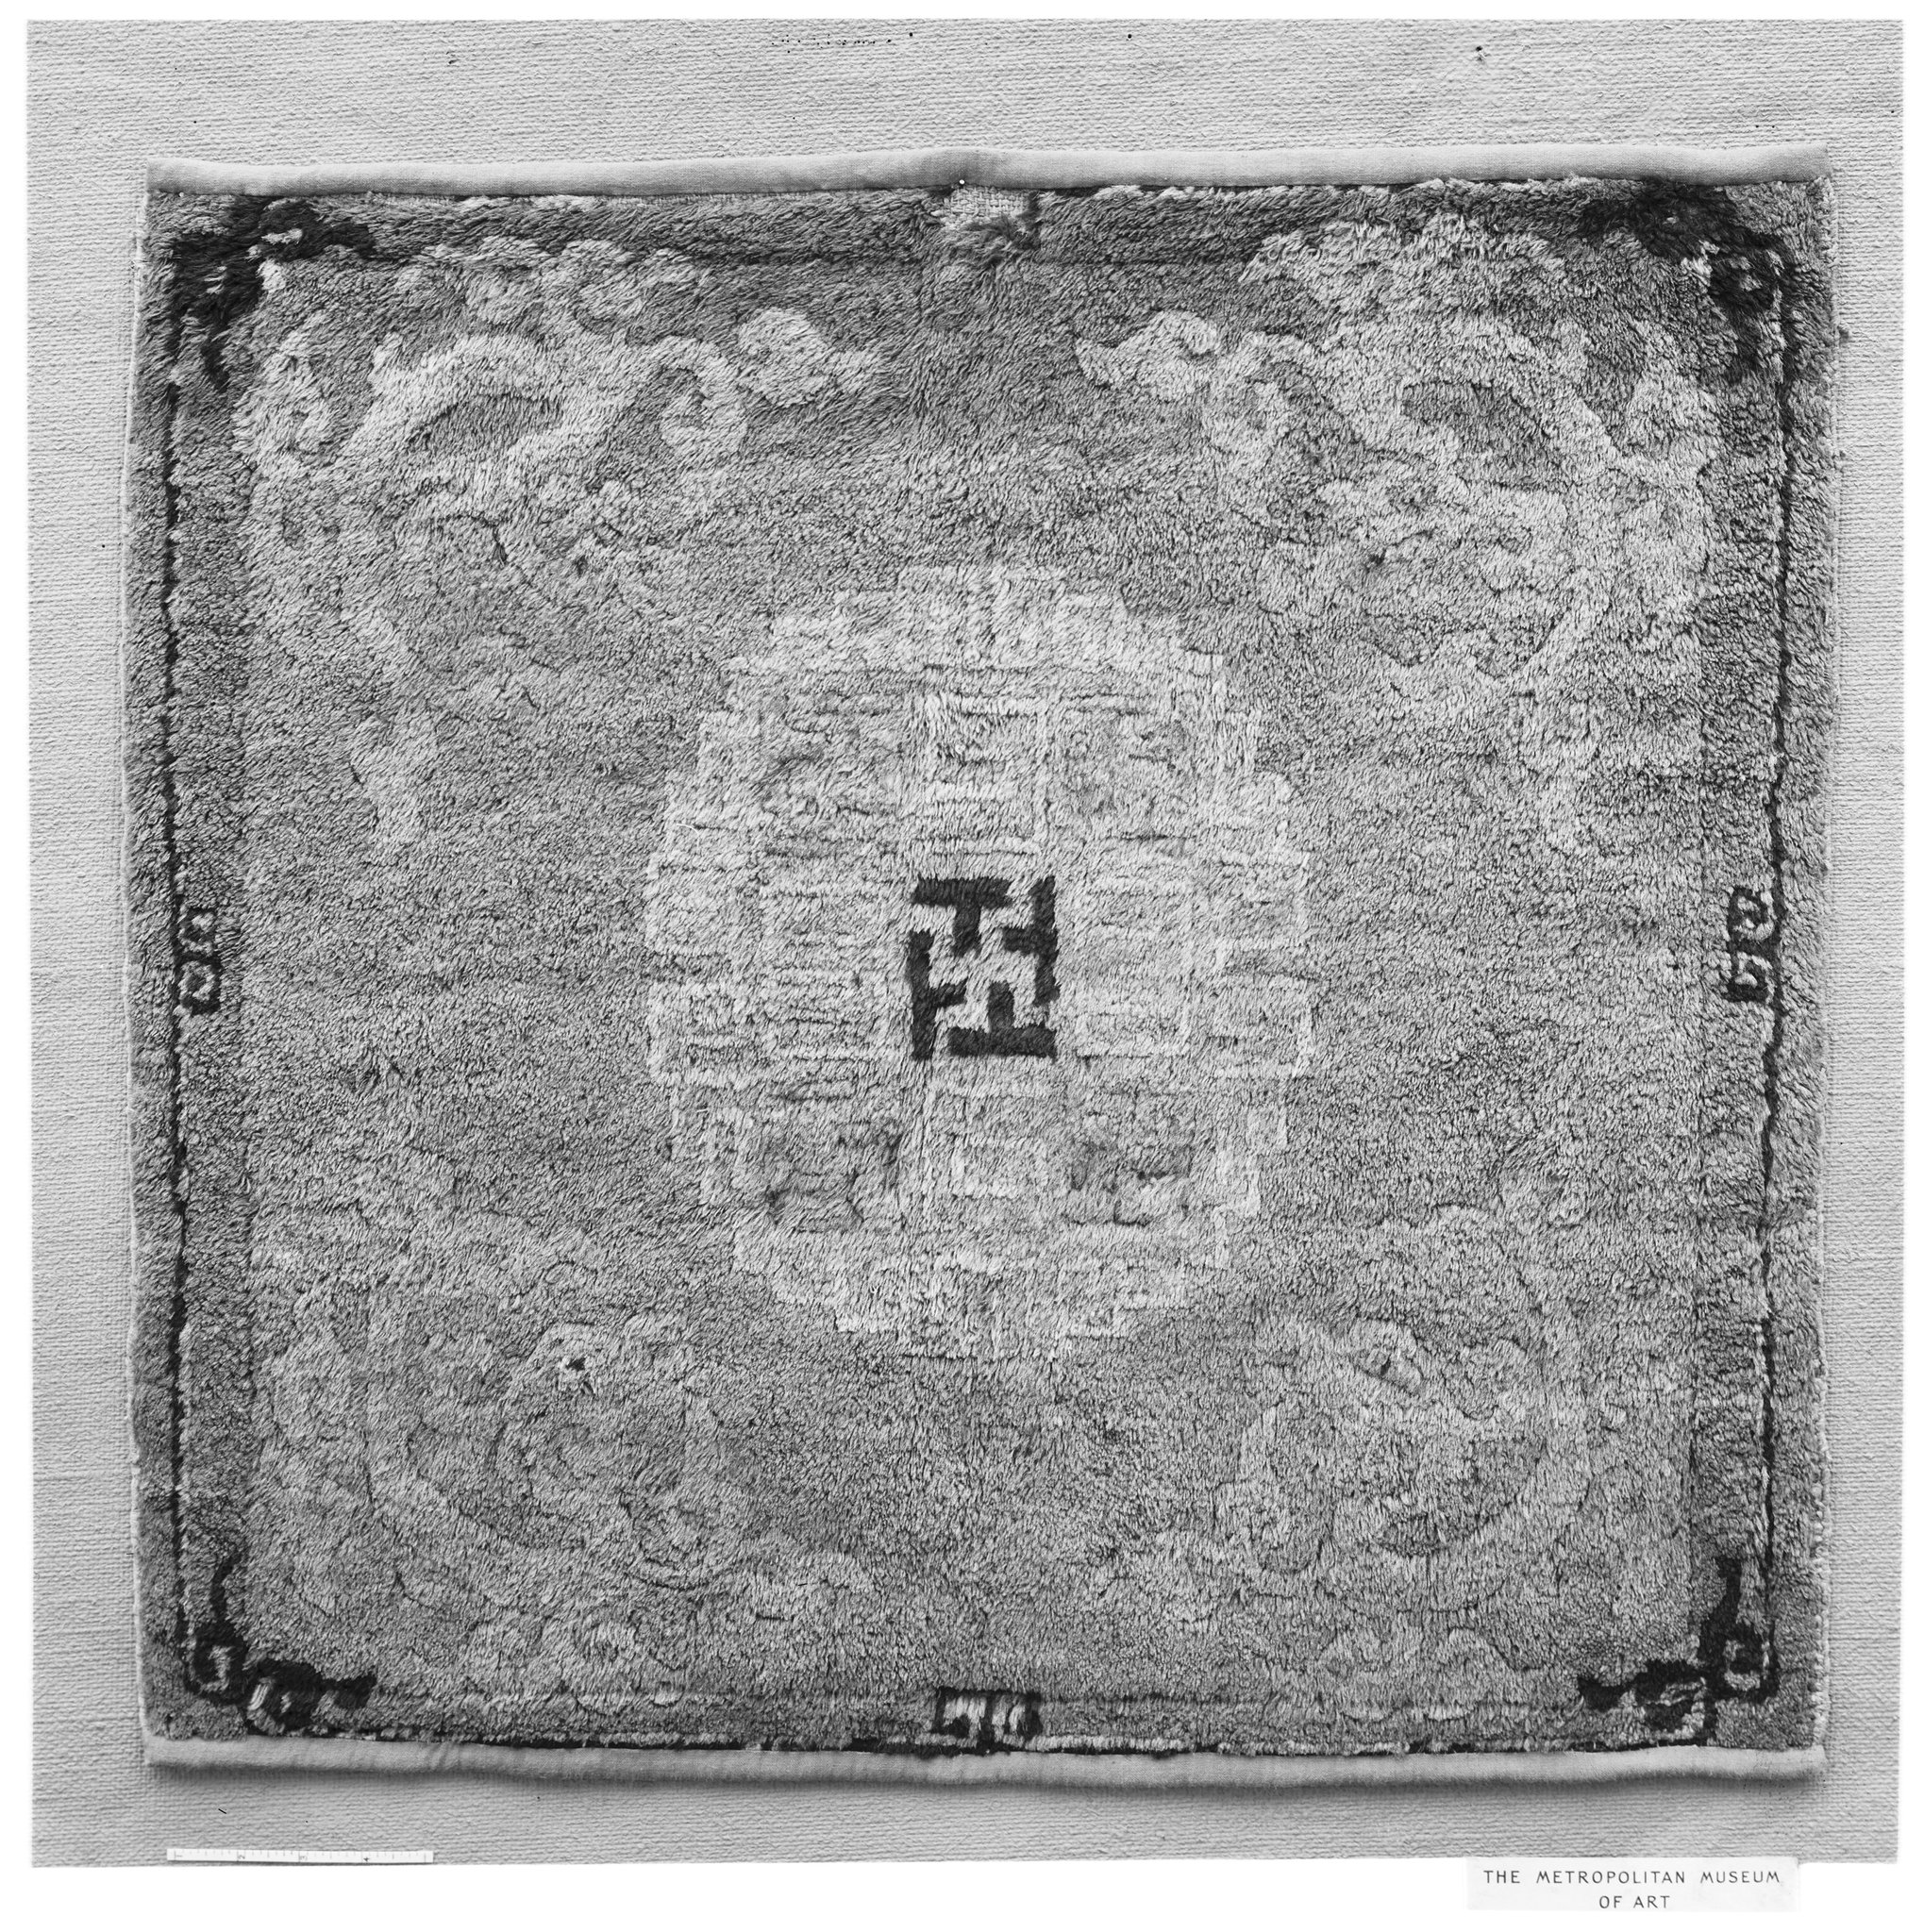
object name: cushion cover or kneeling mat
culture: chinese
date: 1662-1722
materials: cotton, wool